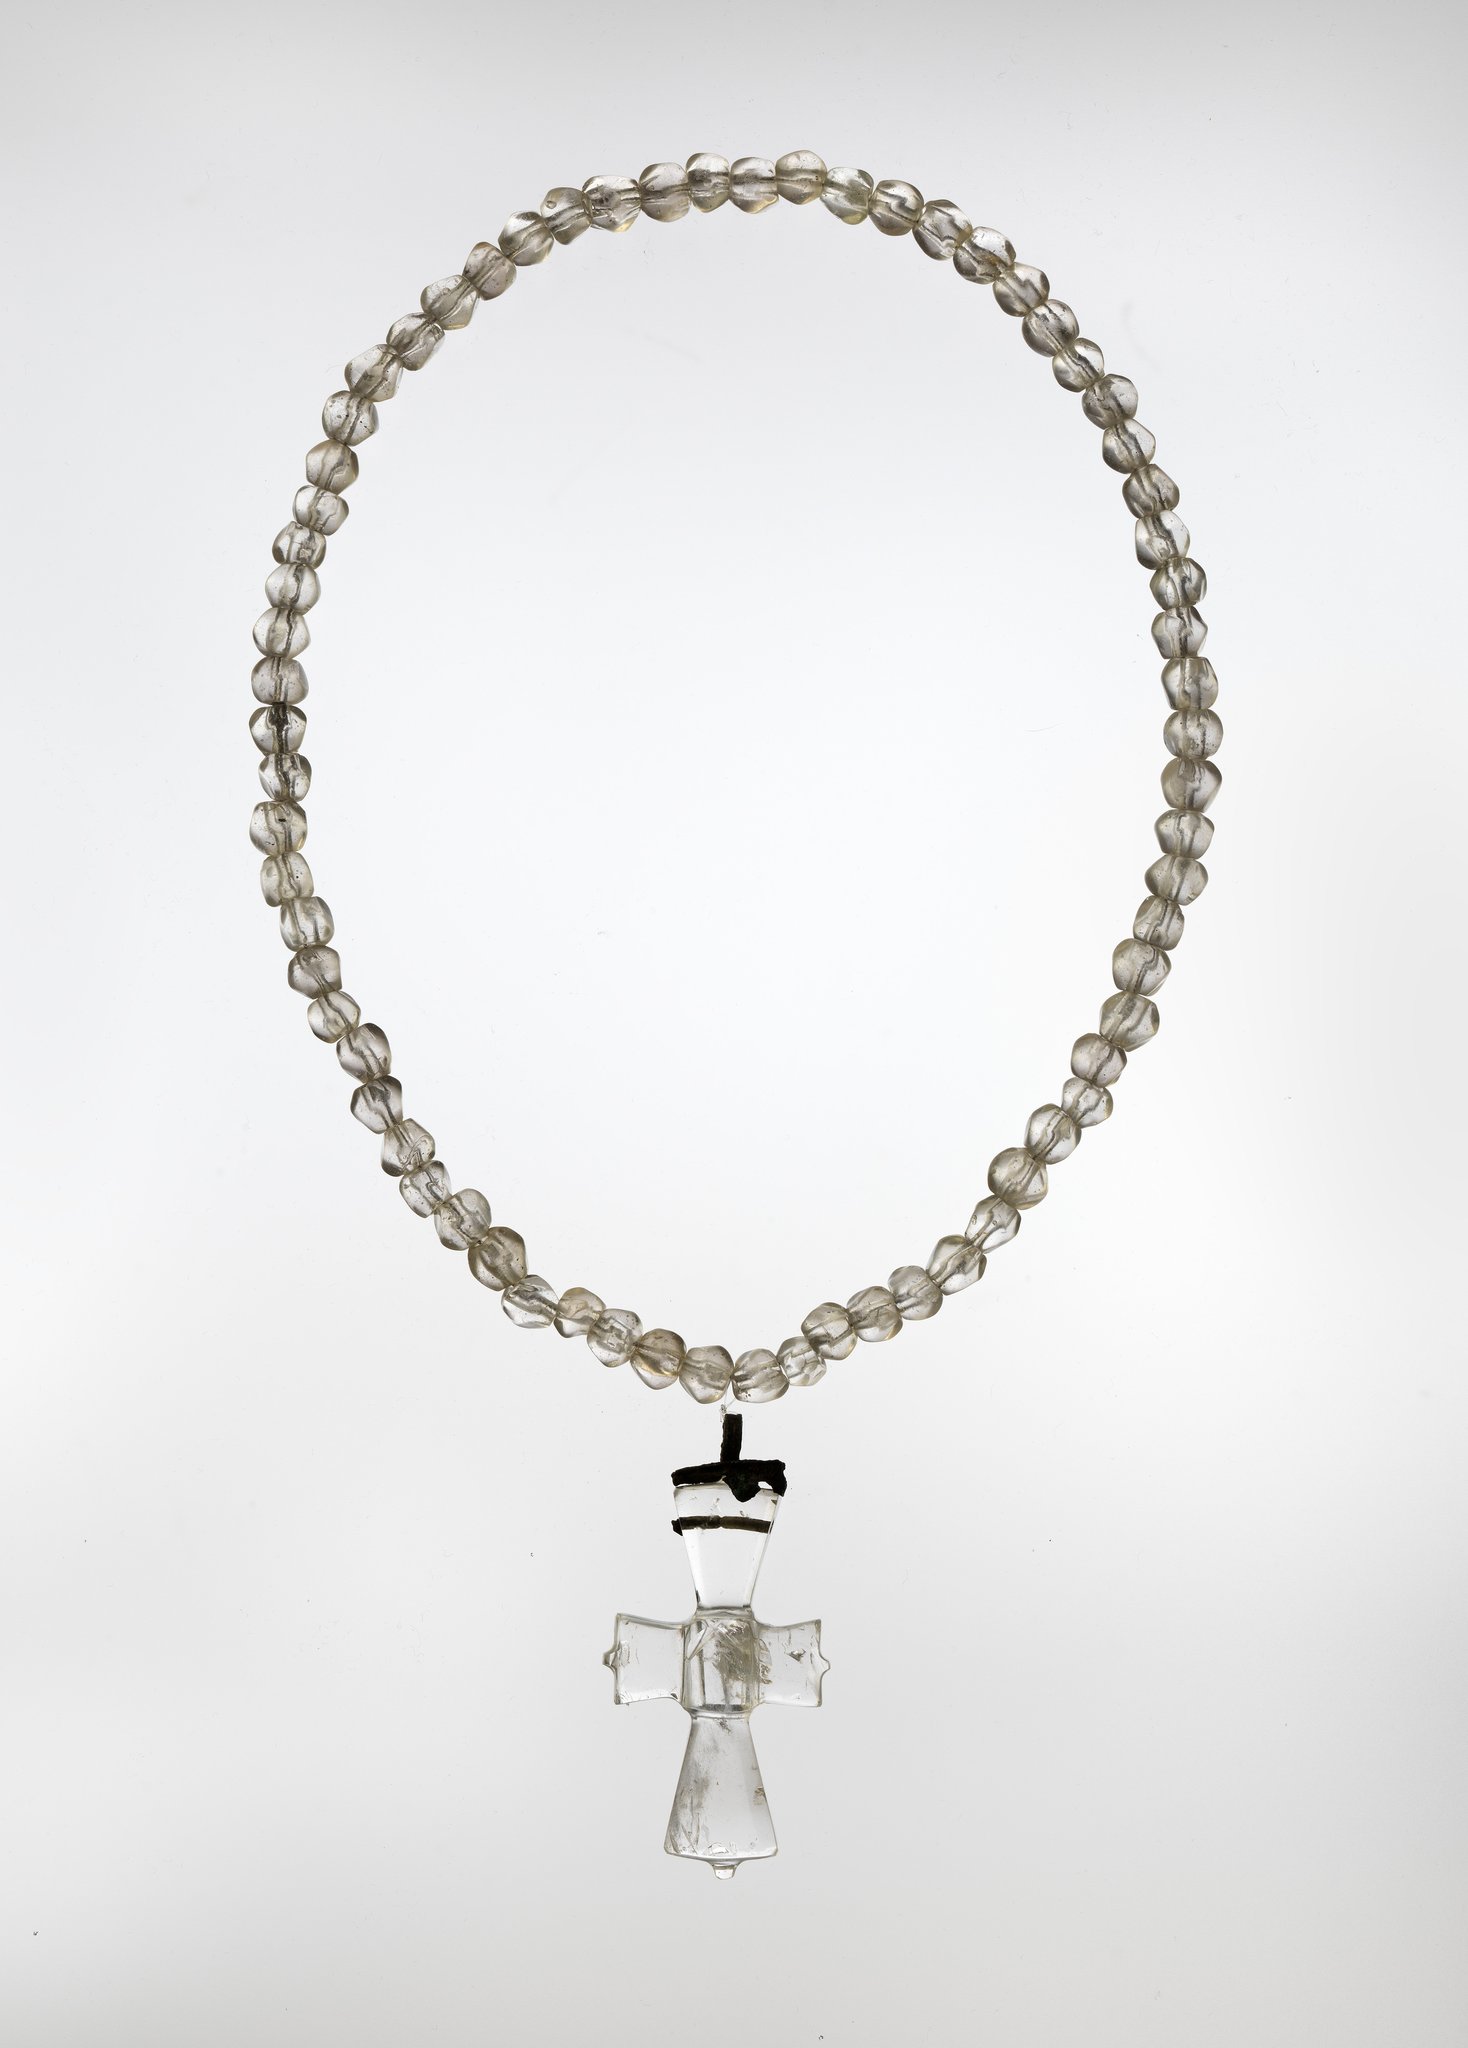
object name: necklace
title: Necklace and Pendant Cross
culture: coptic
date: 500-700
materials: quartz, silver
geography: egypt